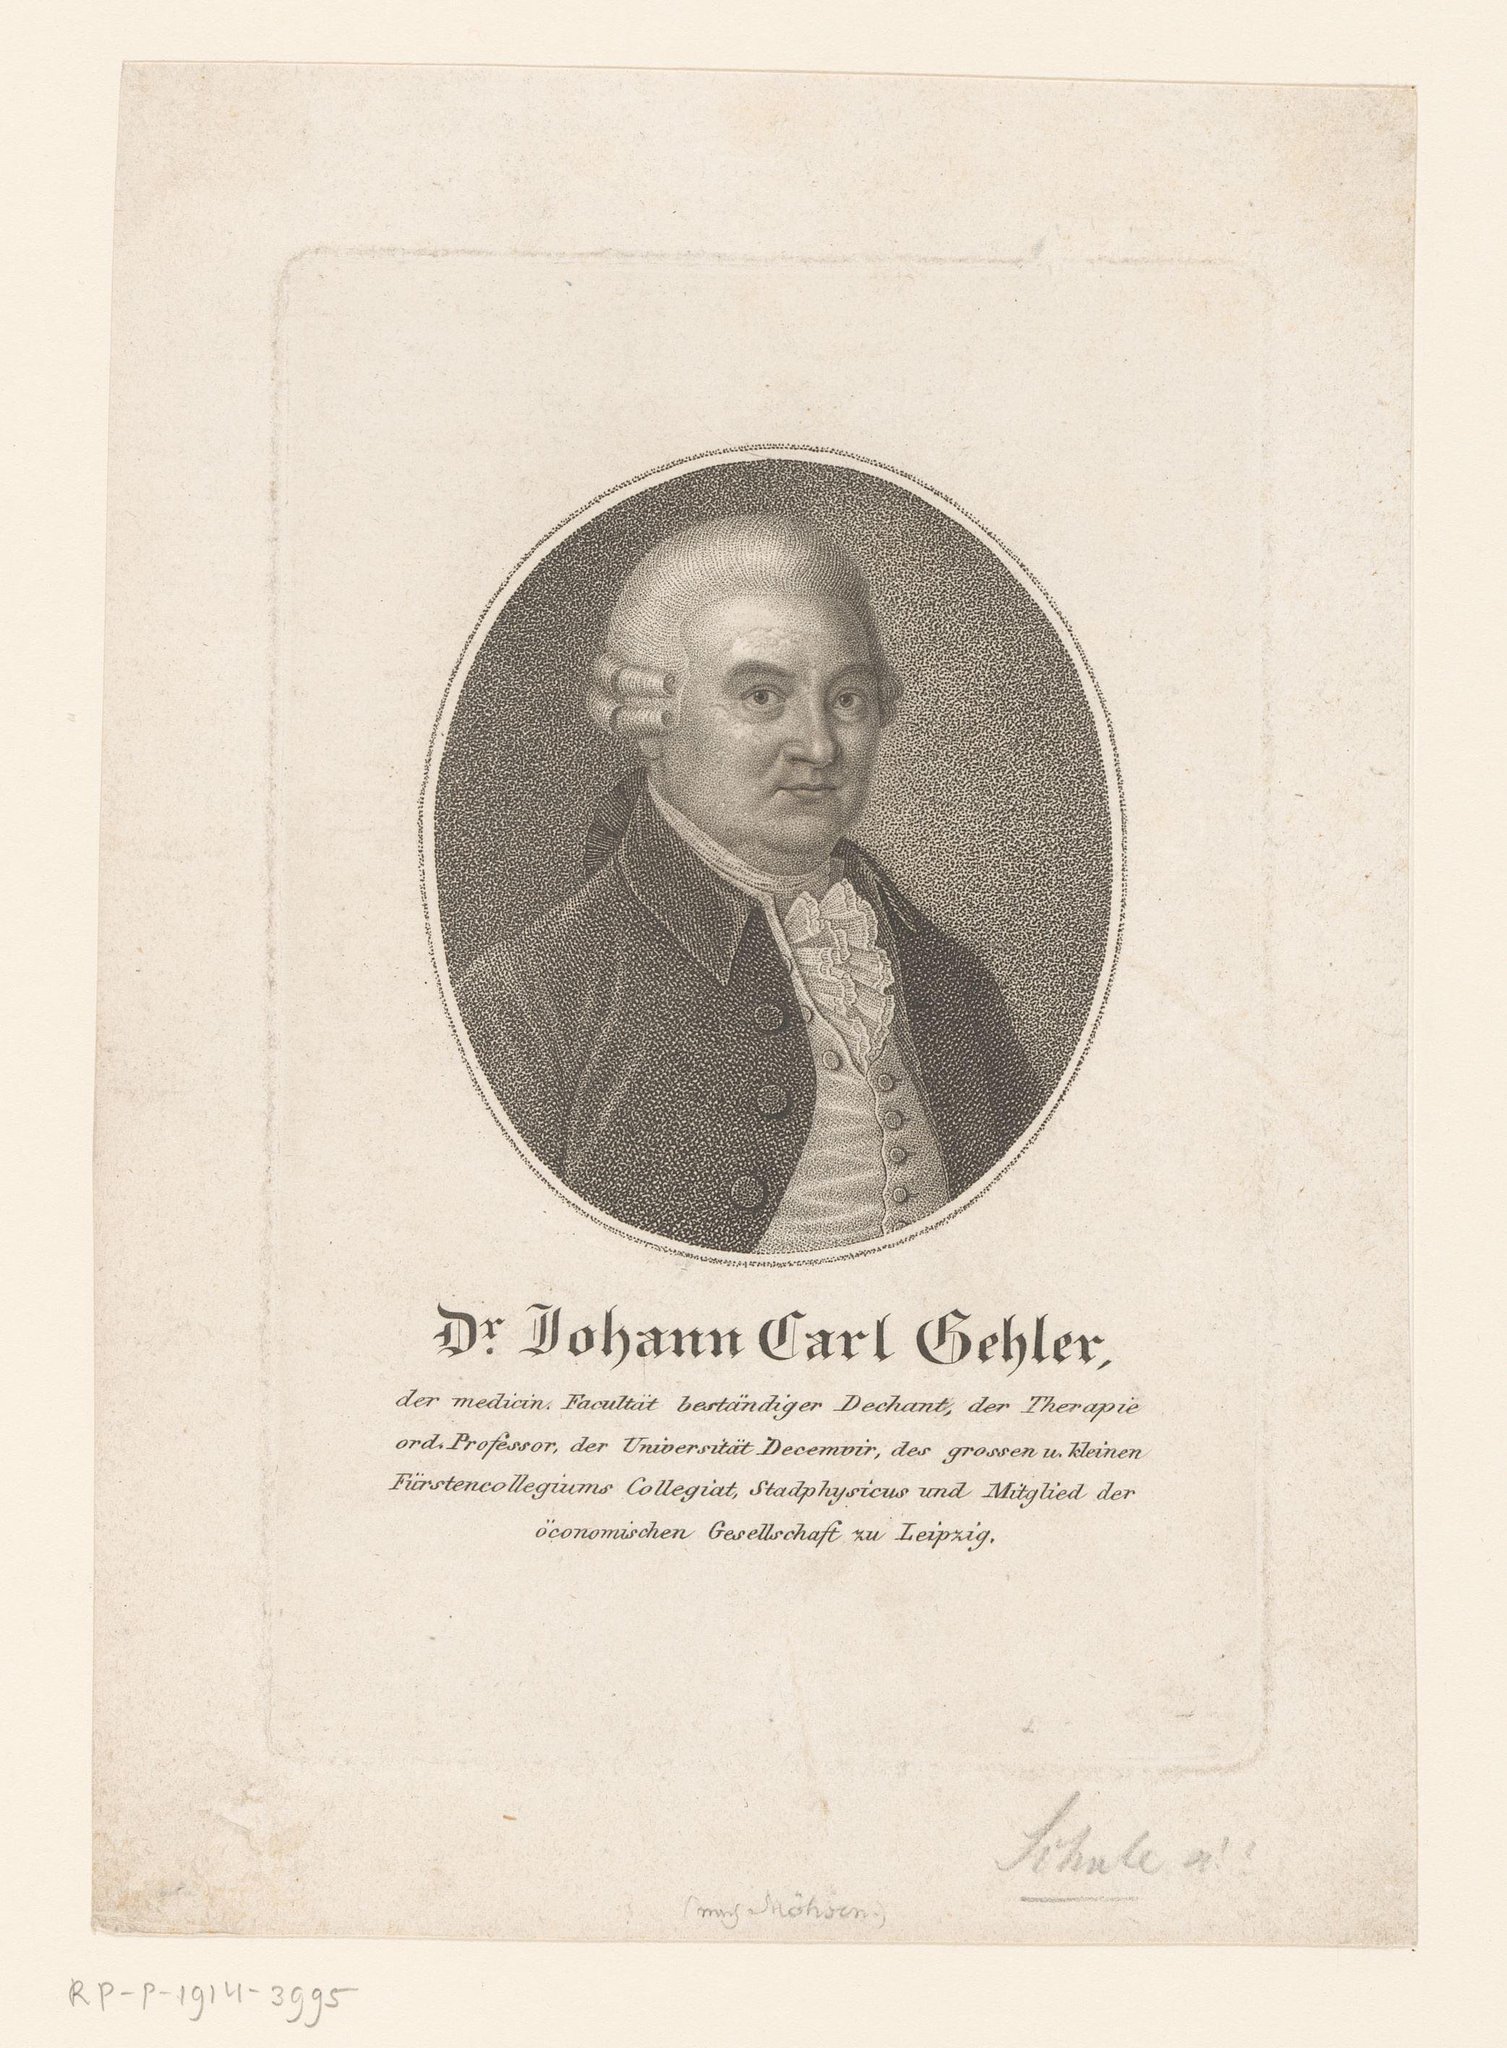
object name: print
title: Dr. Johann Carl Gehler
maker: christian schule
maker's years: 1764-1816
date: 1774-1816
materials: paper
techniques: engraving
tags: historical persons, medical research, branches of medicine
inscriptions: collector's mark: Lugt 2228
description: Portret van Johann Carl Gehler, Duits wetenschapper in Leipzig.